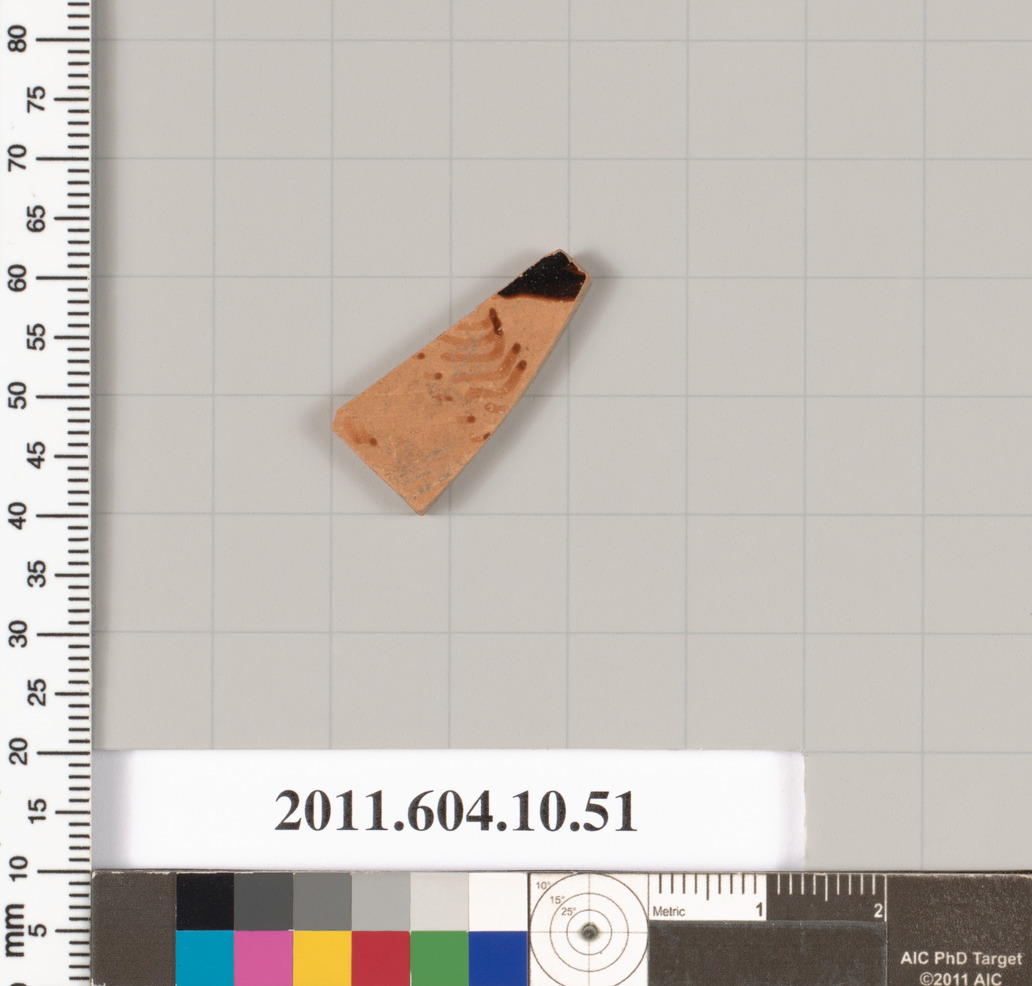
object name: kylix fragment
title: Terracotta fragment of a kylix (drinking cup)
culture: etruscan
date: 334-301 BCE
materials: terracotta